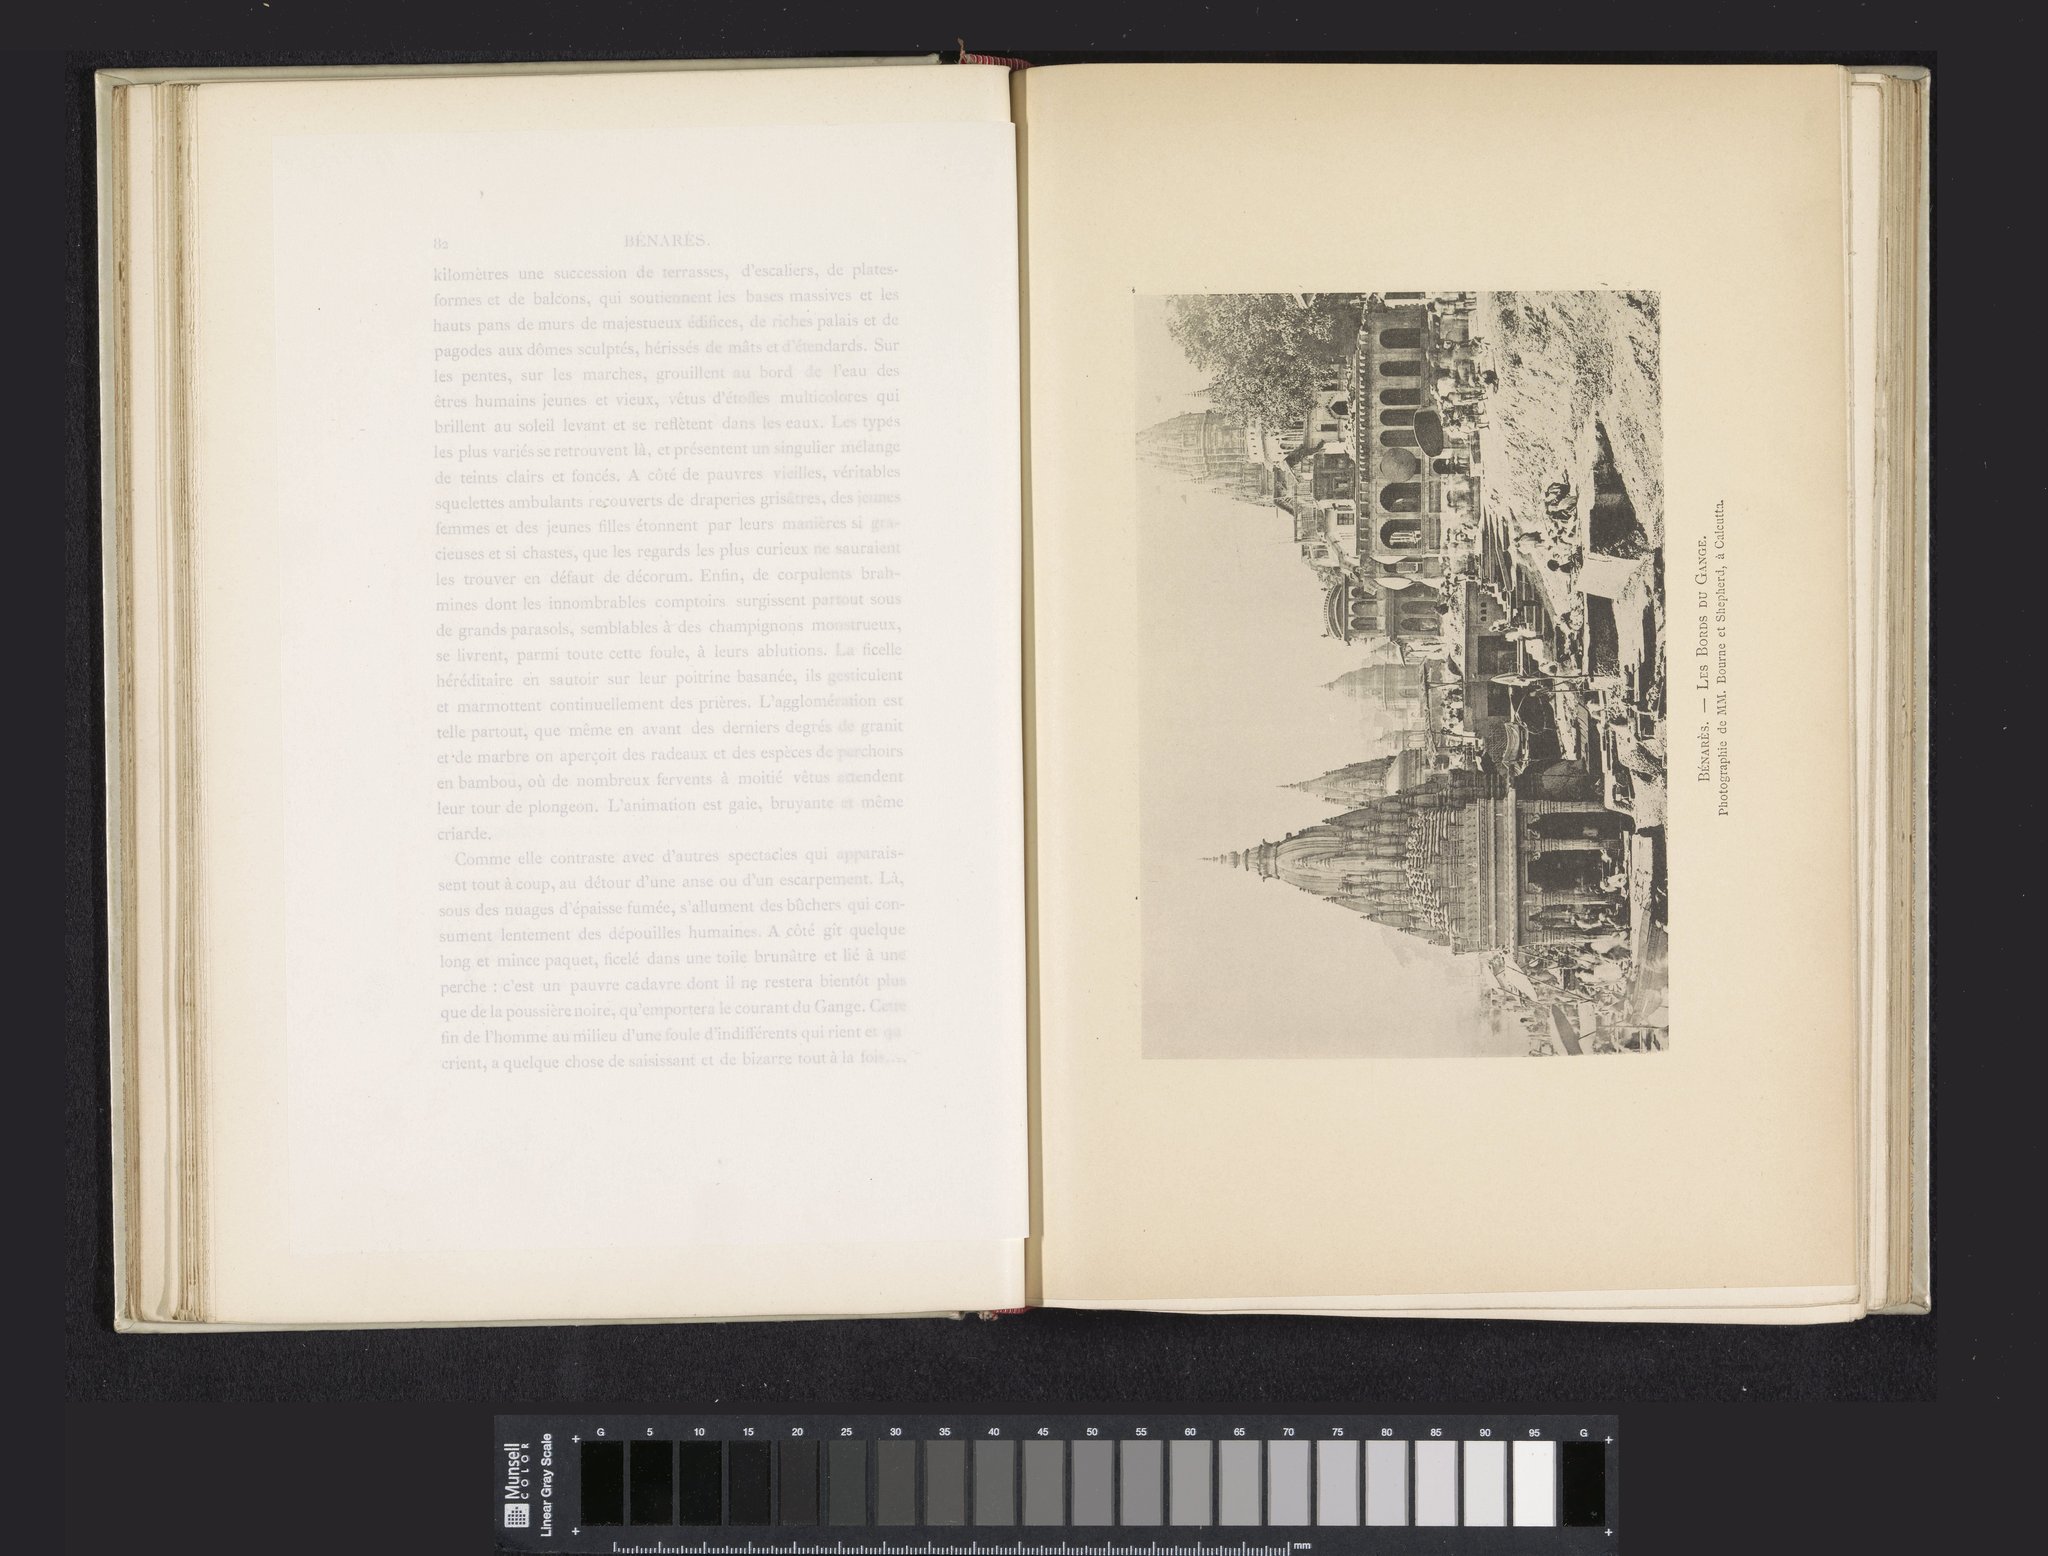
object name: photomechanical print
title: Bénarès. - Les Bords du Gange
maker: Anonymous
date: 1875-1884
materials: paper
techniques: photograph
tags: temple, shrine ~ hinduism, buddhism, jainism, river, façade (of house or building)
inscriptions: inscription: ‘Photographie de MM. Bourne et Shepherd, à Calcutta.’